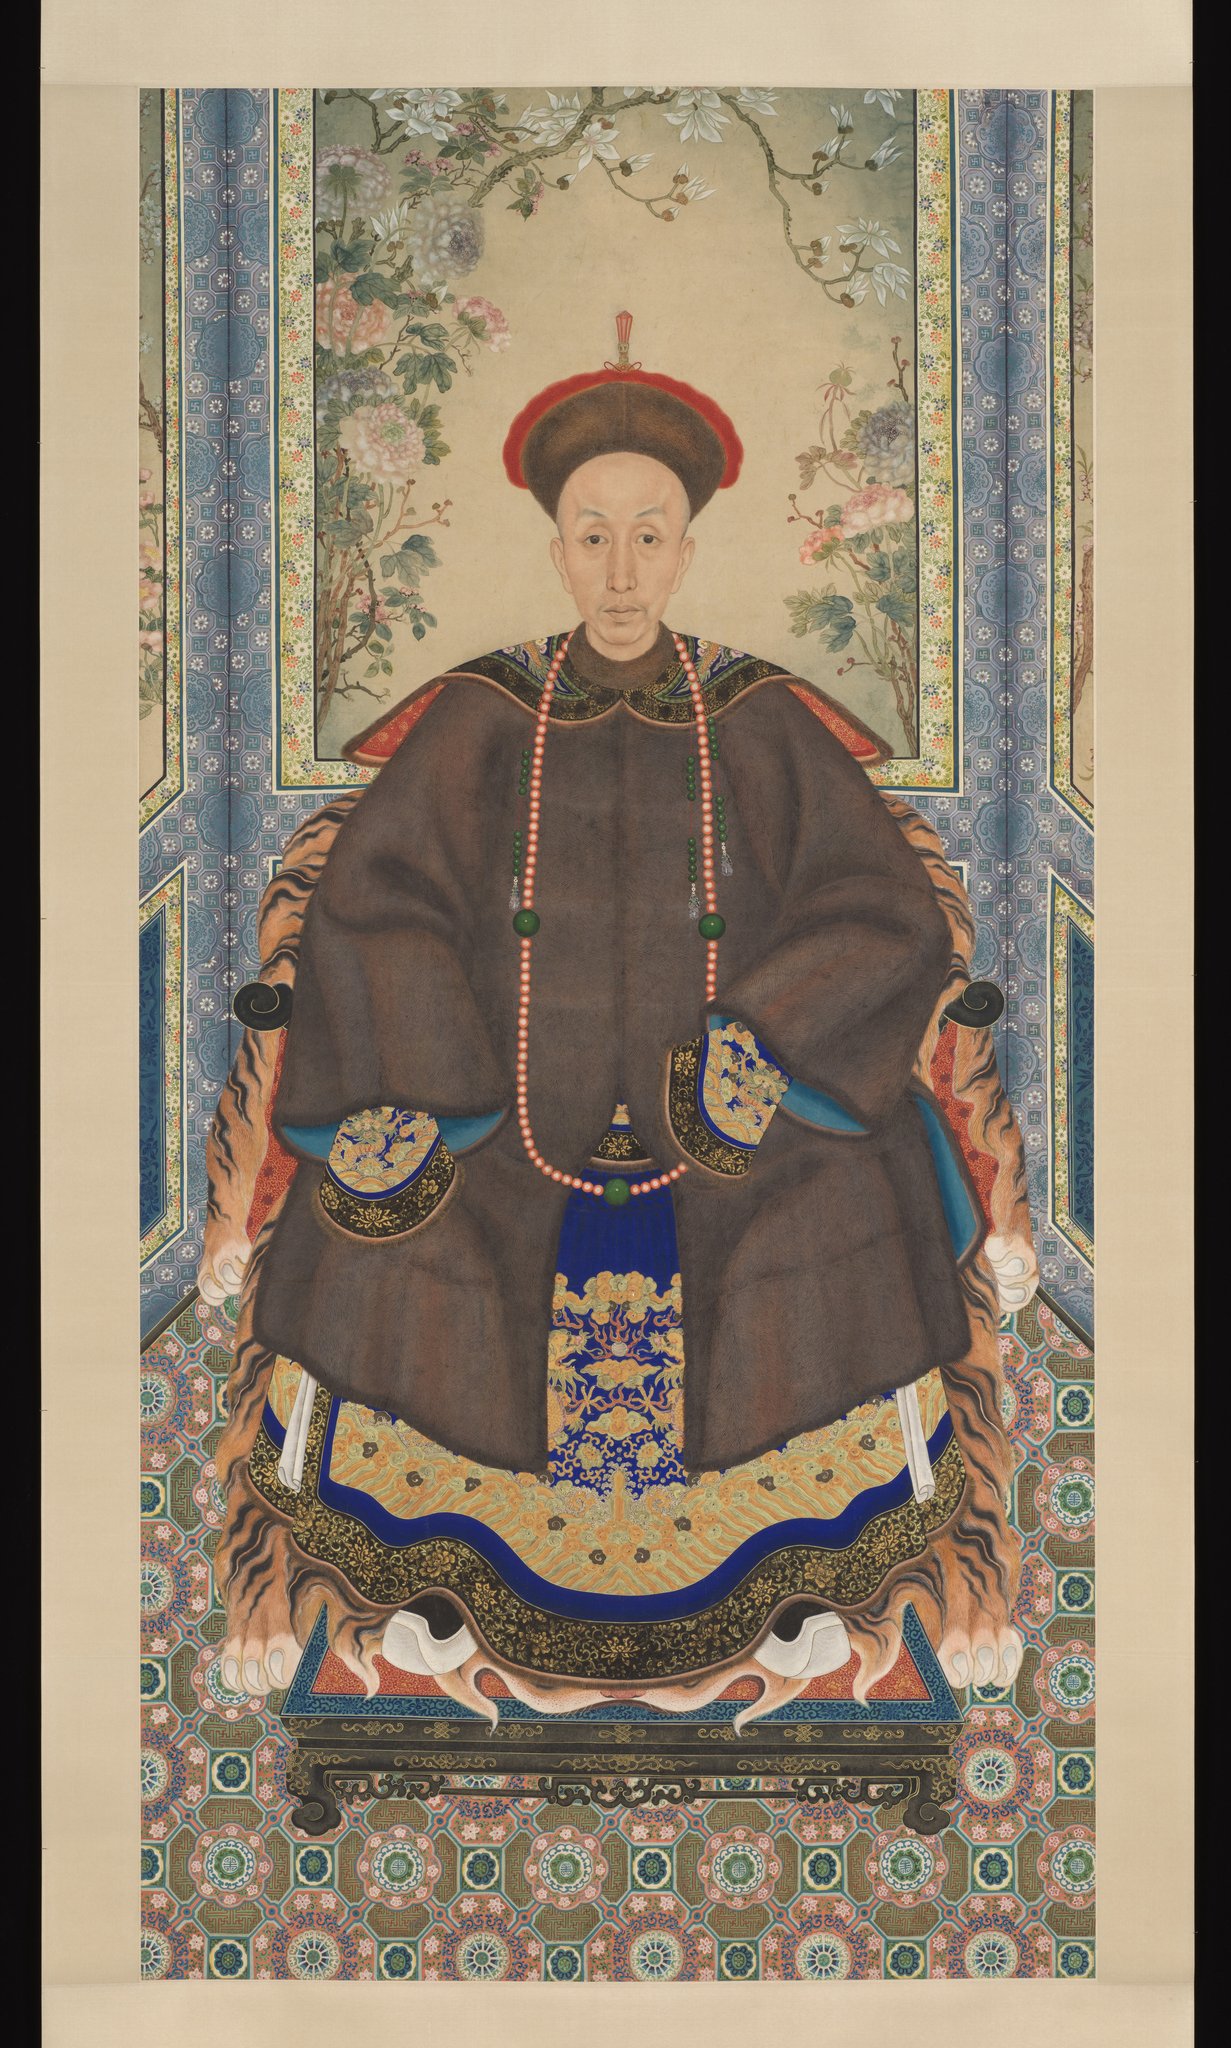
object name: hanging scroll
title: Portrait of a man in court robes with fur surcoat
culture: chinese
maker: unidentified artist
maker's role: artist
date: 1767-1833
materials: ink, paper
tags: men,portraits